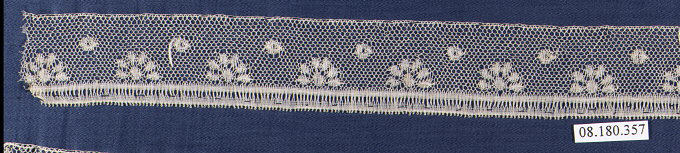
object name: piece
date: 1801-1900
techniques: lace